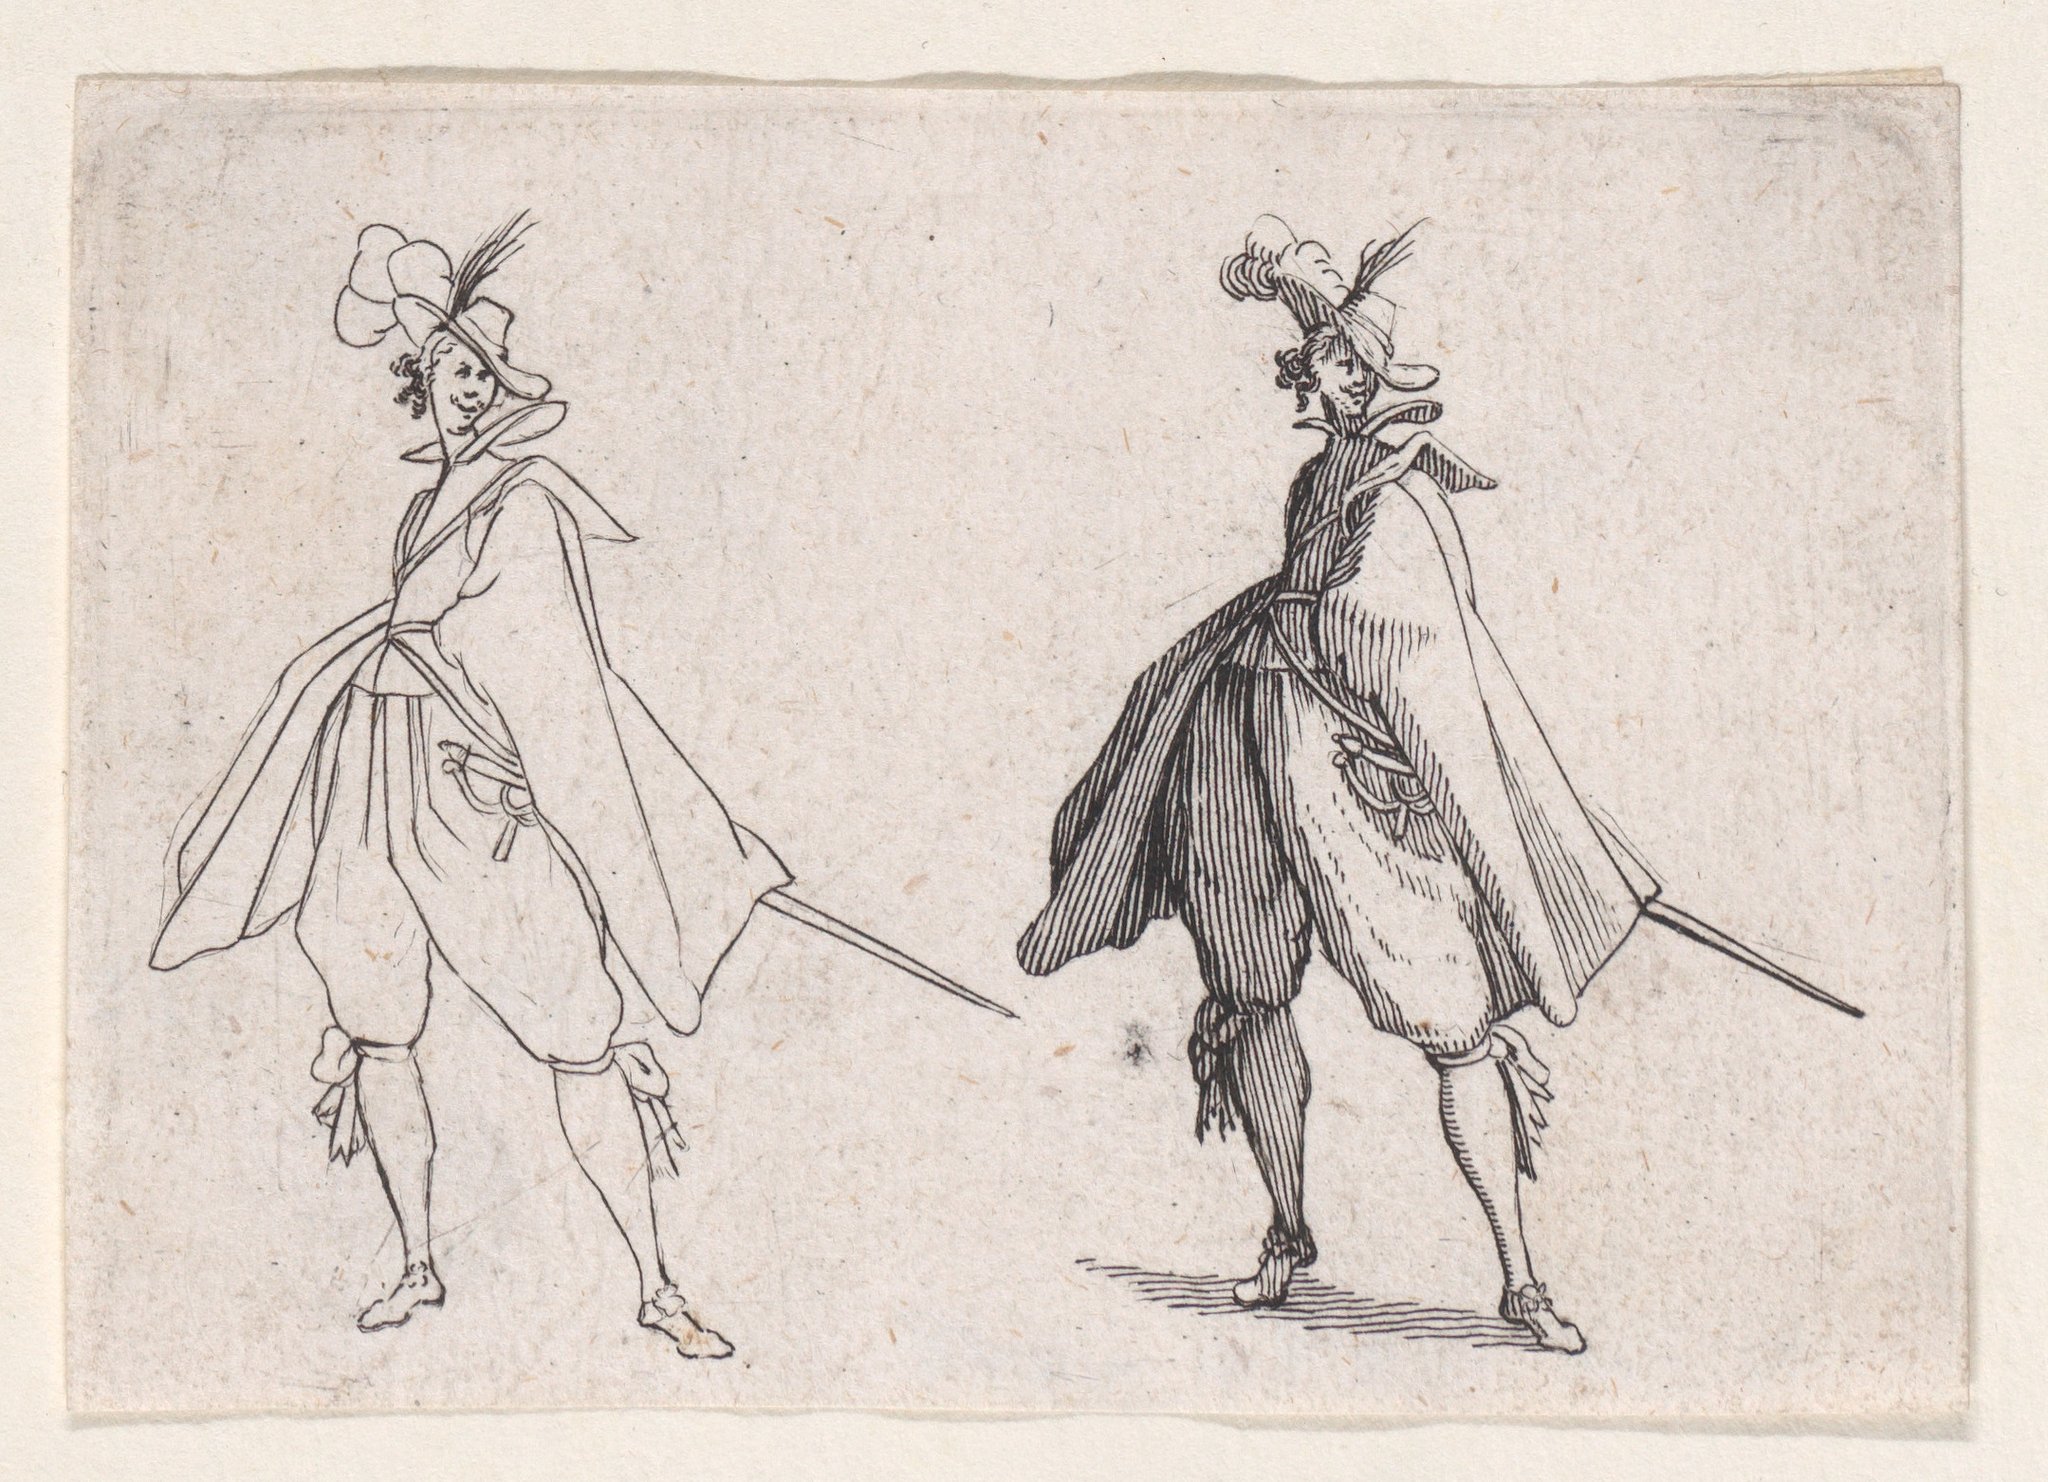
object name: print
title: Copy of Le Gentilhomme au Grand Manteau, Vu de Face (Gentleman with a Large Mantle, Viewed from the Front), from "Les Caprices" Series A, The Florence Set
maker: Anonymous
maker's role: artist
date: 1601-1700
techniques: etching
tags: men